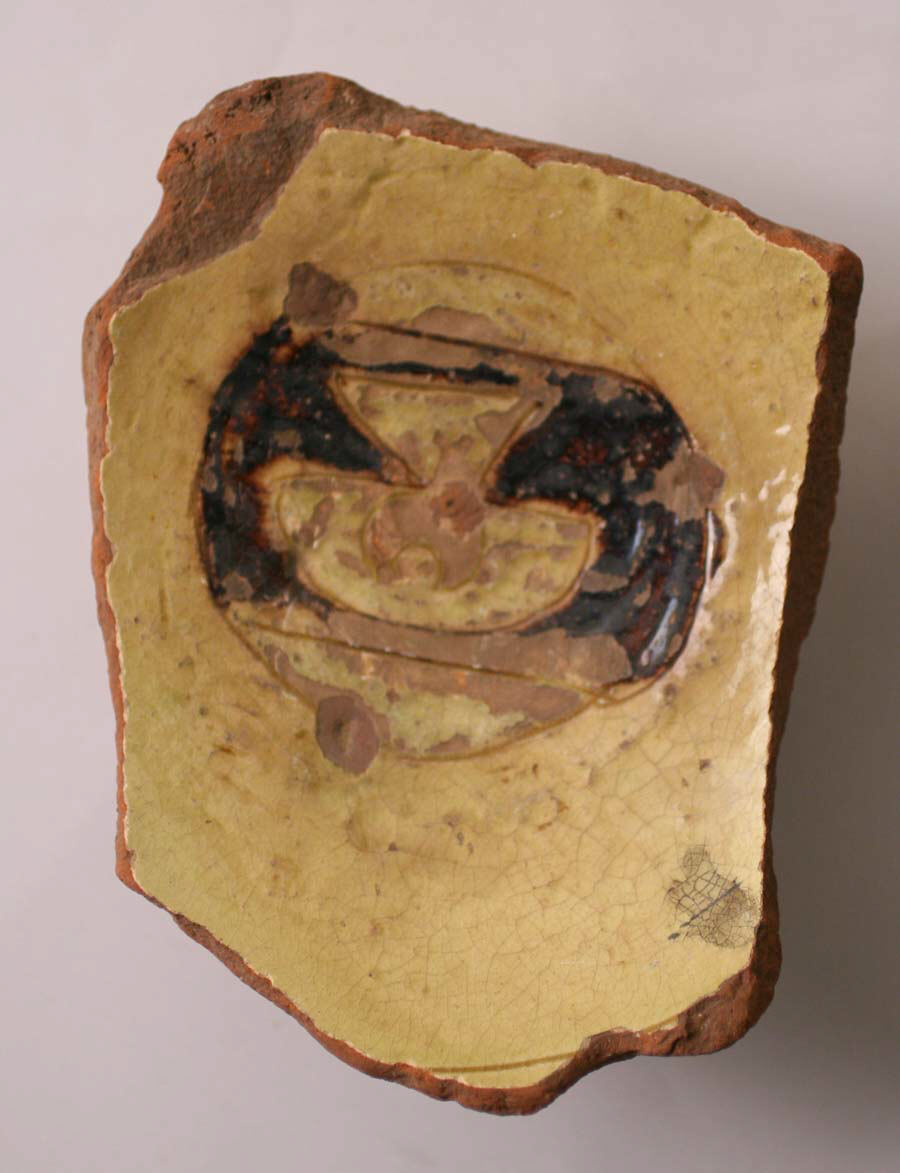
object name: ceramic fragment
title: Fragment of a Bowl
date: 1301-1500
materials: earthenware, glaze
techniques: coloring, incising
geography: egypt